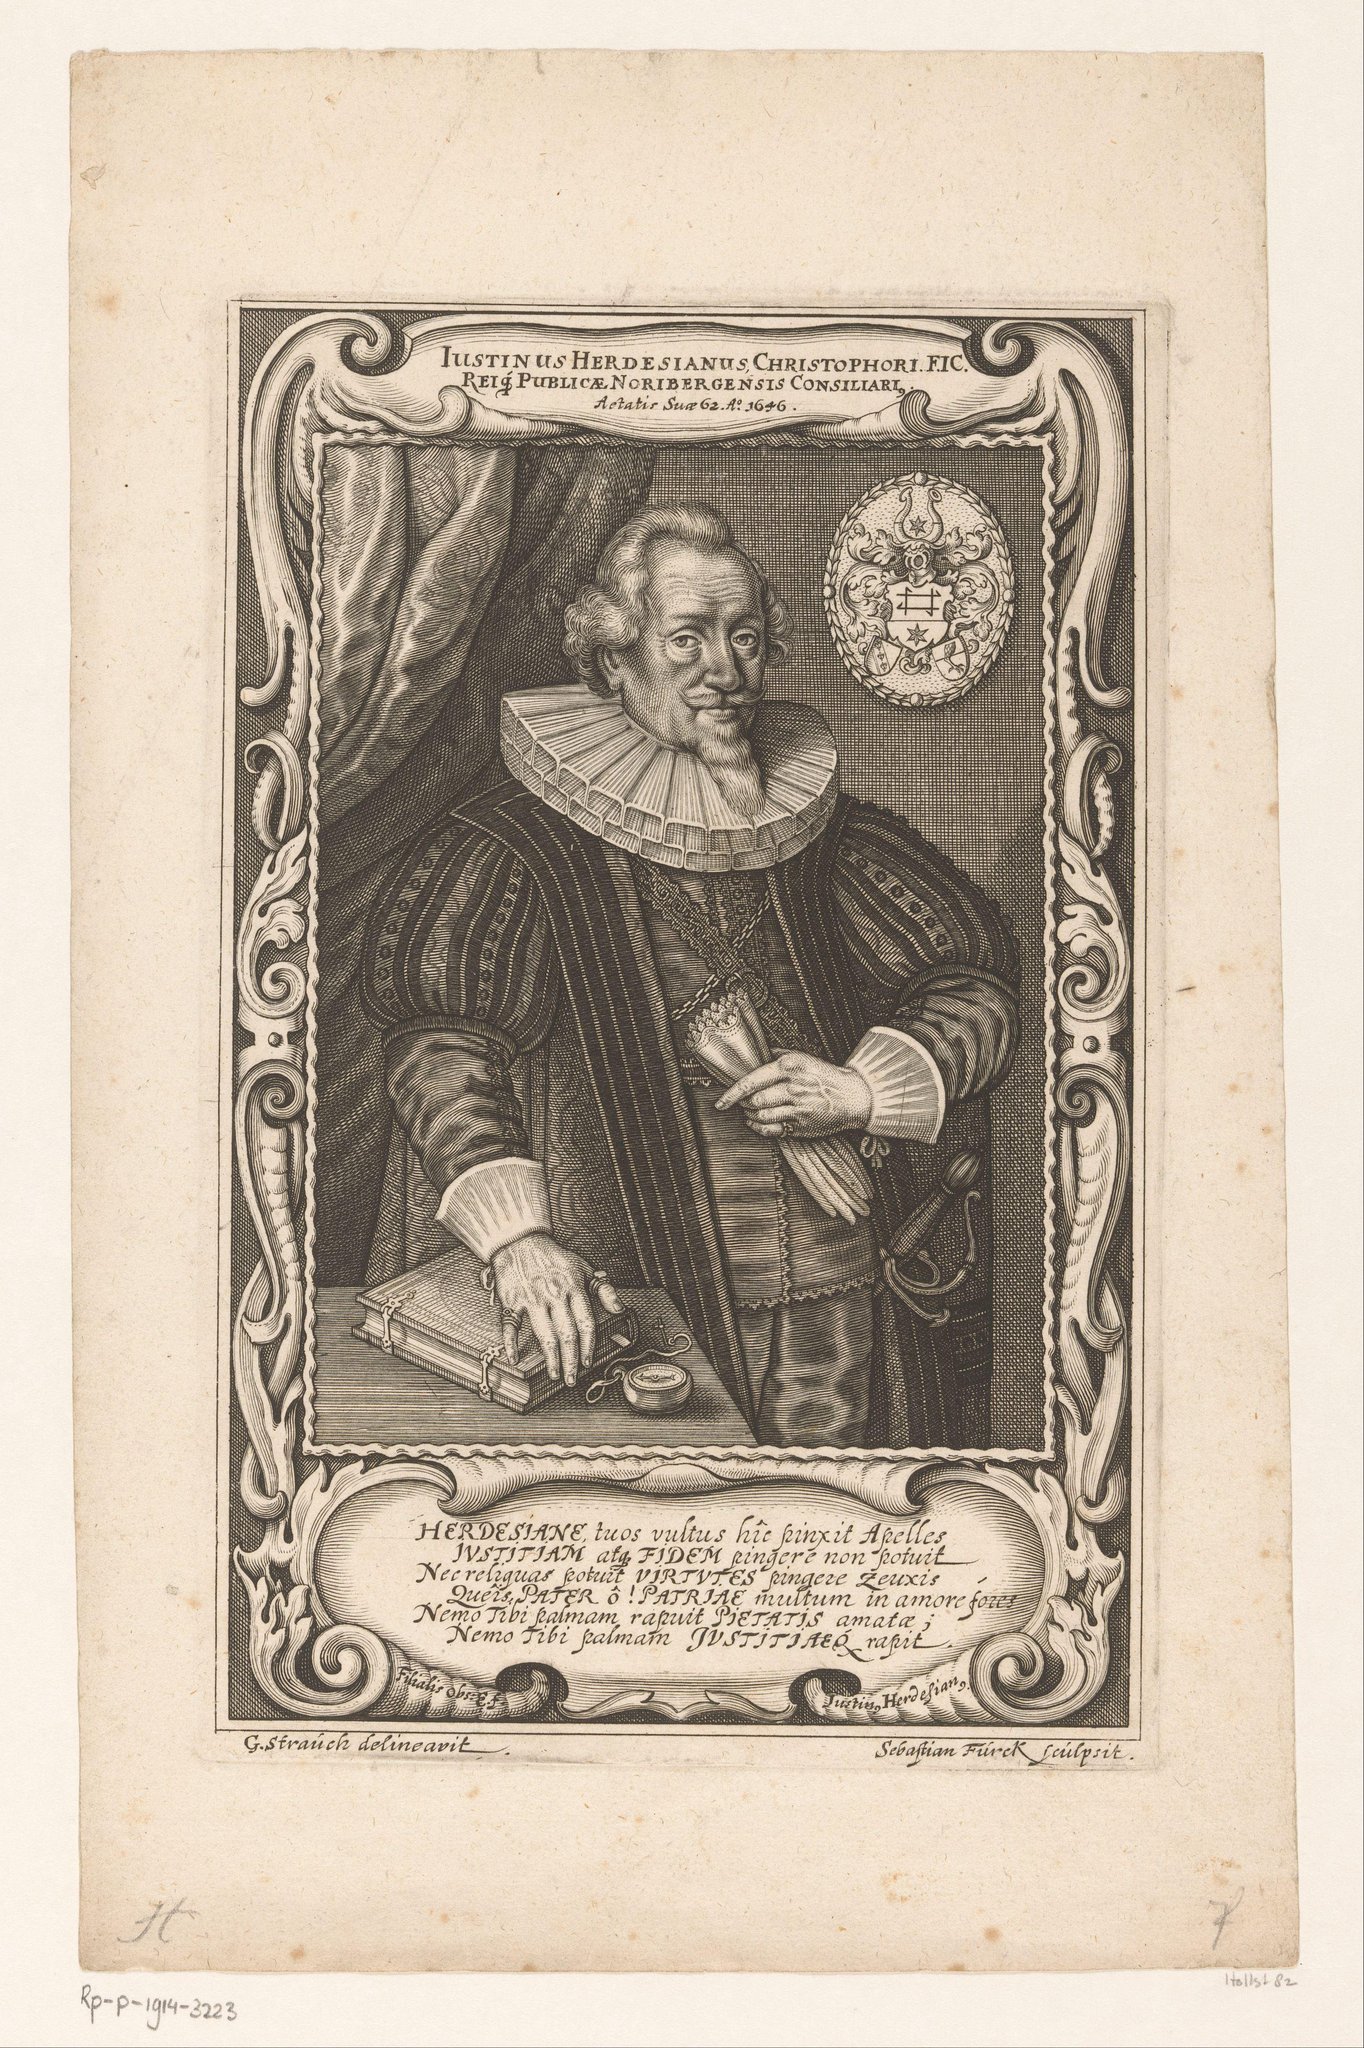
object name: print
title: Portret van Justin Herdesian op 62-jarige leeftijd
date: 1646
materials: paper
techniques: engraving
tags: gloves, mittens, etc., historical persons, book, ornament ~ cartouche, compass, armorial bearing, heraldry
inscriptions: collector's mark: Lugt 2228